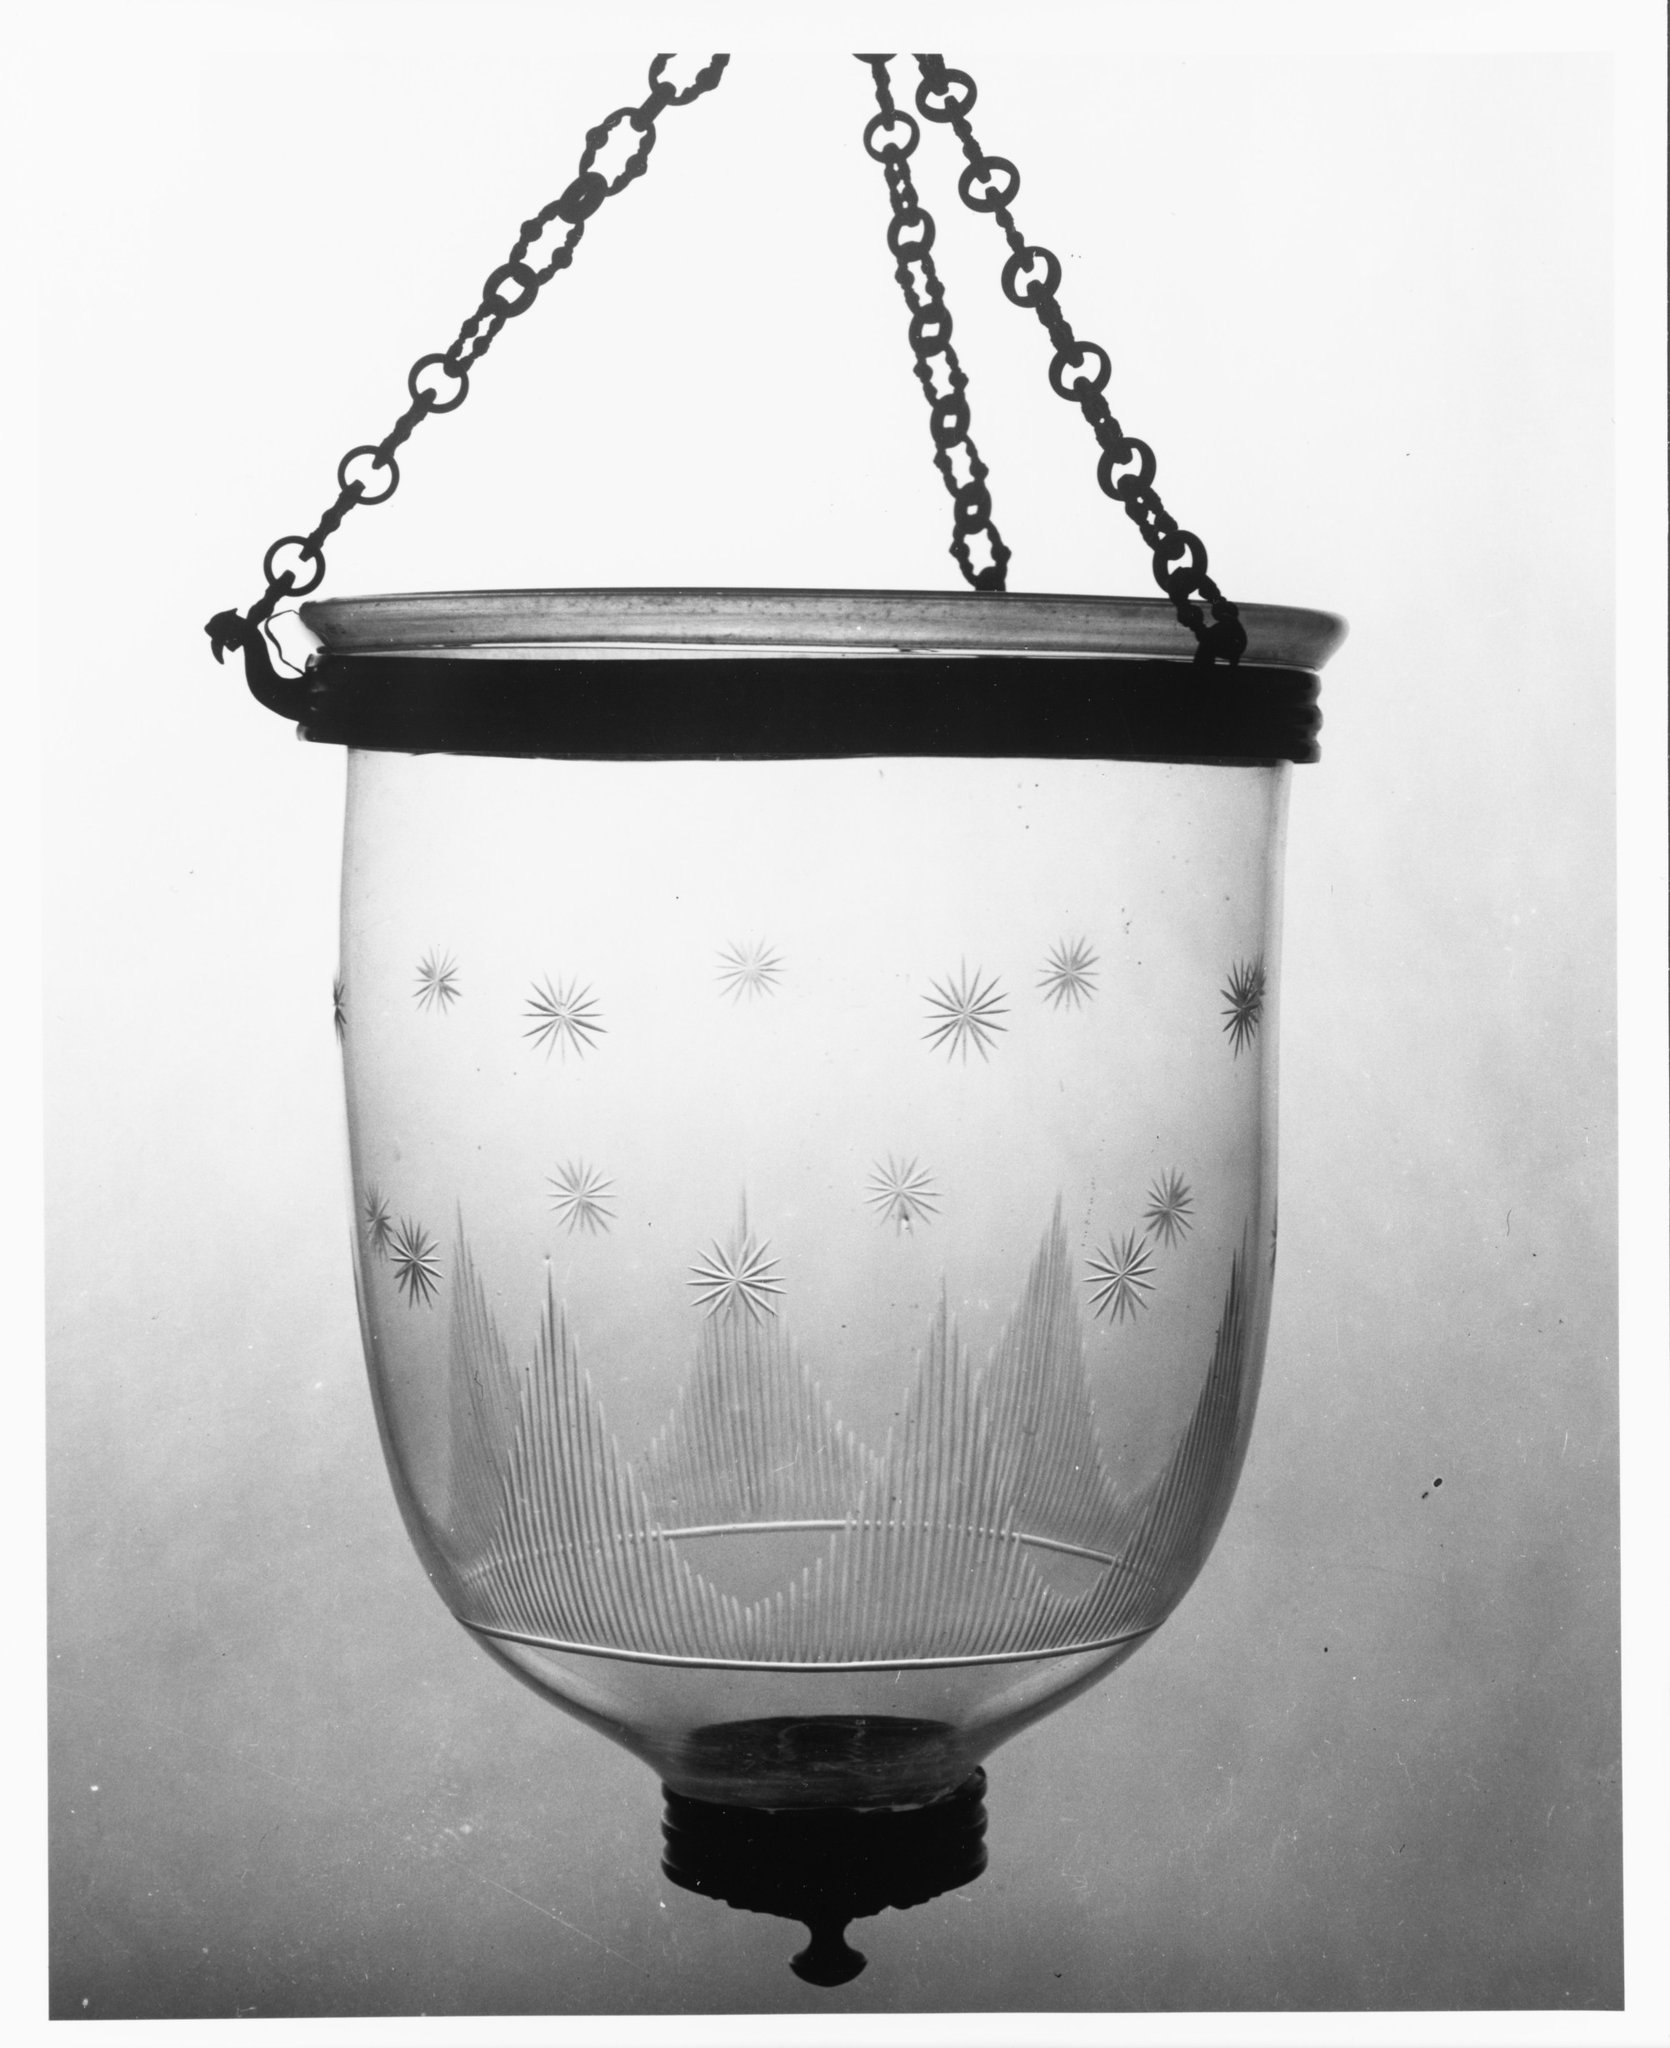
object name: lantern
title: Hanging Lantern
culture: american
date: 1800-1825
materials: brass, glass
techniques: glassblowing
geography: united states